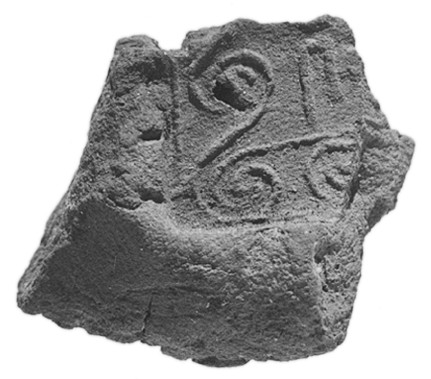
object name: sealing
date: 2030-1640 BCE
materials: clay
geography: egypt